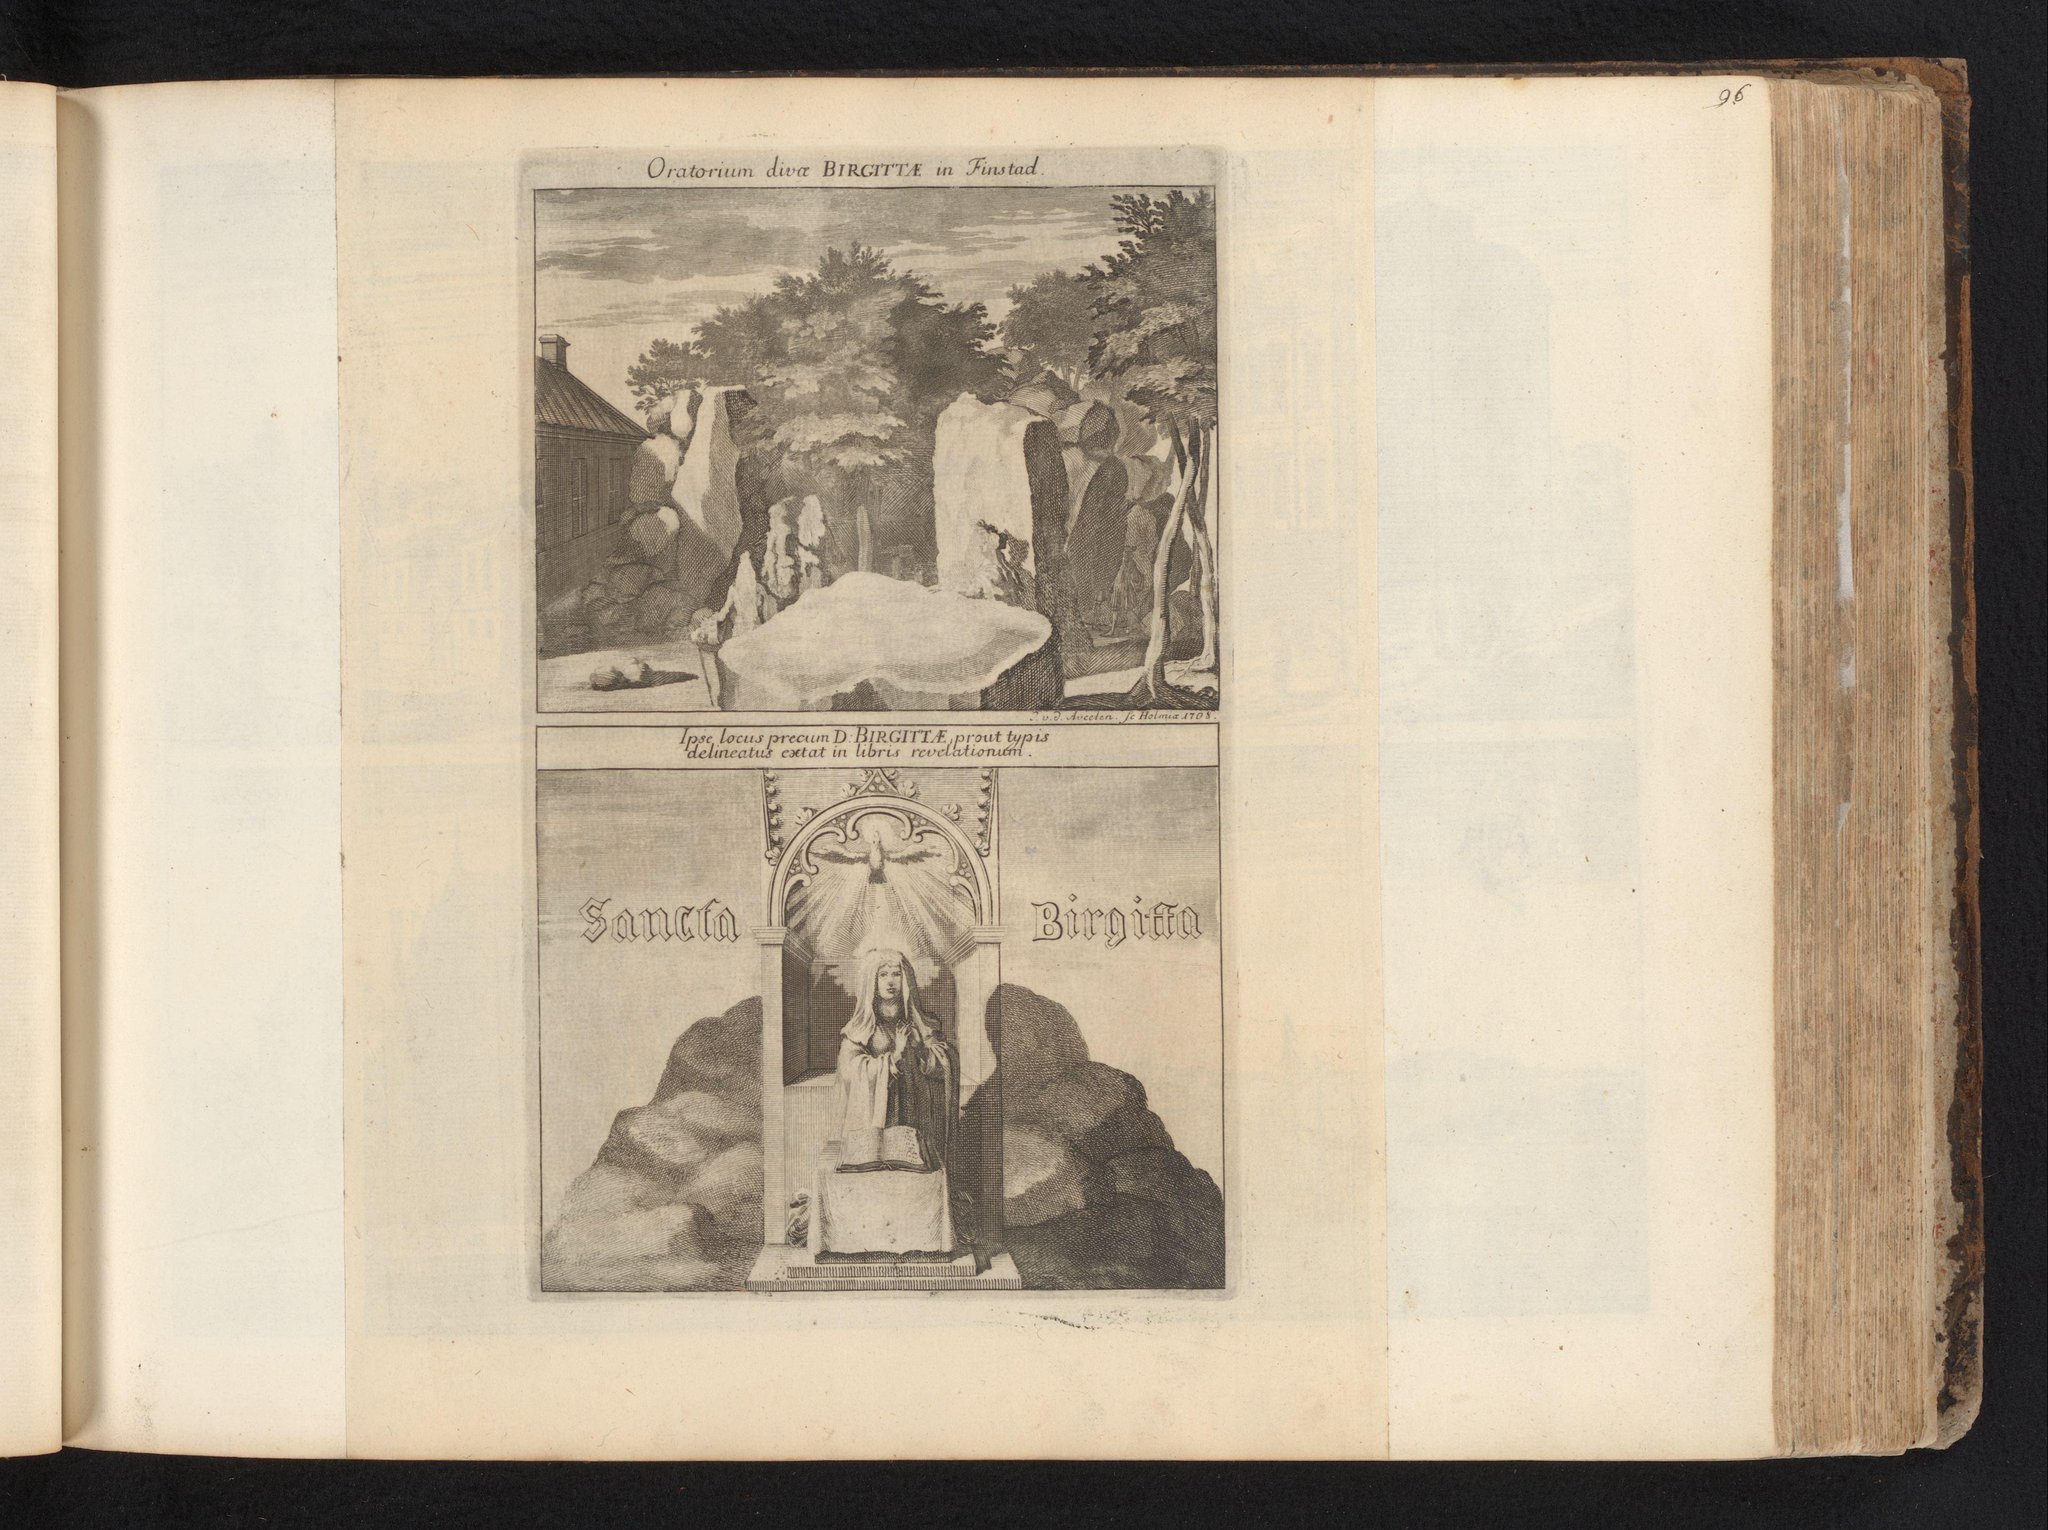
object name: album leaf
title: Oratorium divae Birgittae in Finstad / Ipse locus precum D: Birgittae prout typis delineatus extat in libris revelationum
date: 1708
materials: paper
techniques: etching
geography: stockholm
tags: the foundress of the order of bri(d)gettines, the widow bridget (birgitta) of sweden; possible attributes: band over veil with five red spots, book, candle, heart with cross, inkhorn, pilgrim's hat, staff, wallet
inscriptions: date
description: Kungliga Biblioteket, 'Suecia': http://www.kb.se/samlingarna/Kartor-bilder/Suecia-antiqua/ (geraadpleegd november 2016).